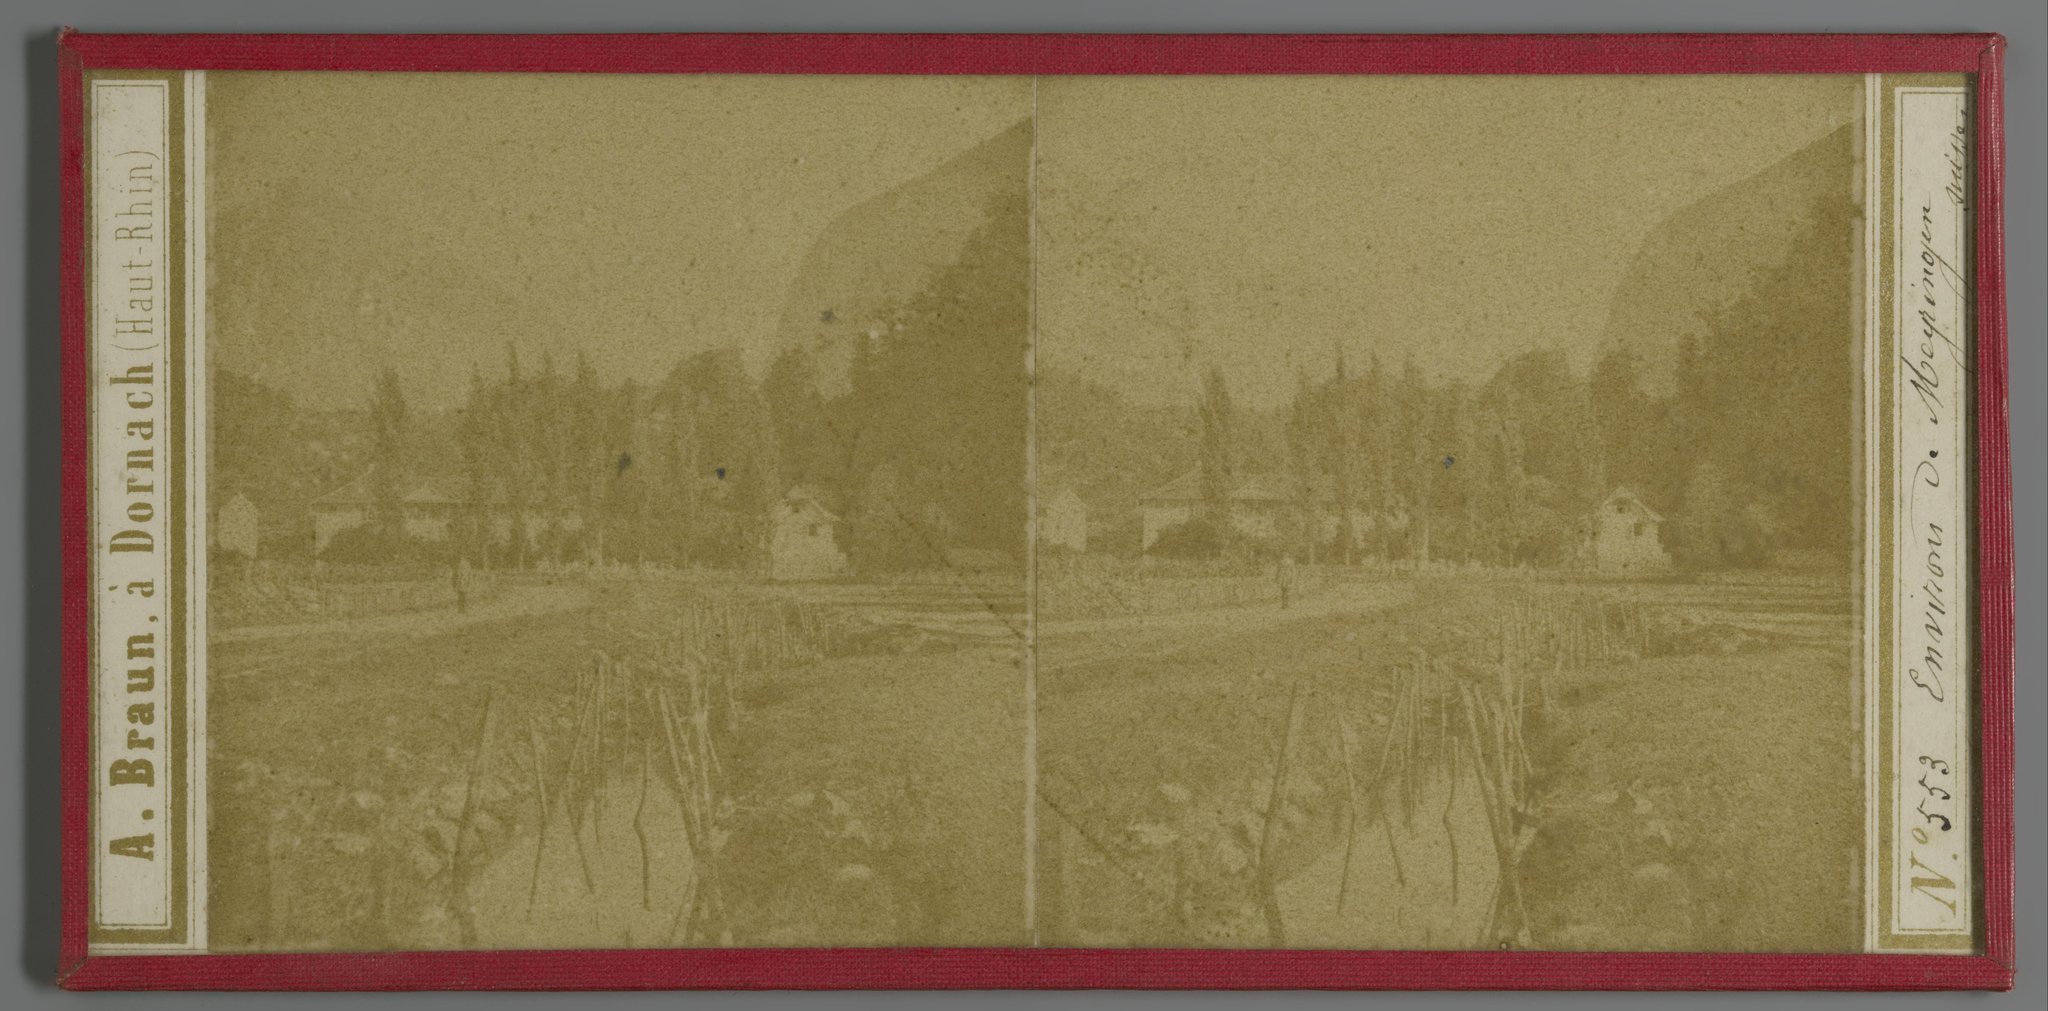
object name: stereoscopic photograph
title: Landschap met gebouwen in de omgeving van Meiringen, Zwitserland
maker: andries jager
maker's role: publisher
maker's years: 1825-1905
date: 1857-1889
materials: cardboard, glass, paper, photographic support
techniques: albumen print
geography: amsterdam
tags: landscapes, rural housing, e.g. country-house, villa, cottage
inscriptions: inscription: ‘A. Braun, à Dornach (Haut-Rhin)’, annotation: ‘No. 533 Environ de Meyringen, Suisse.’, name: ‘M L P Kistemaker’